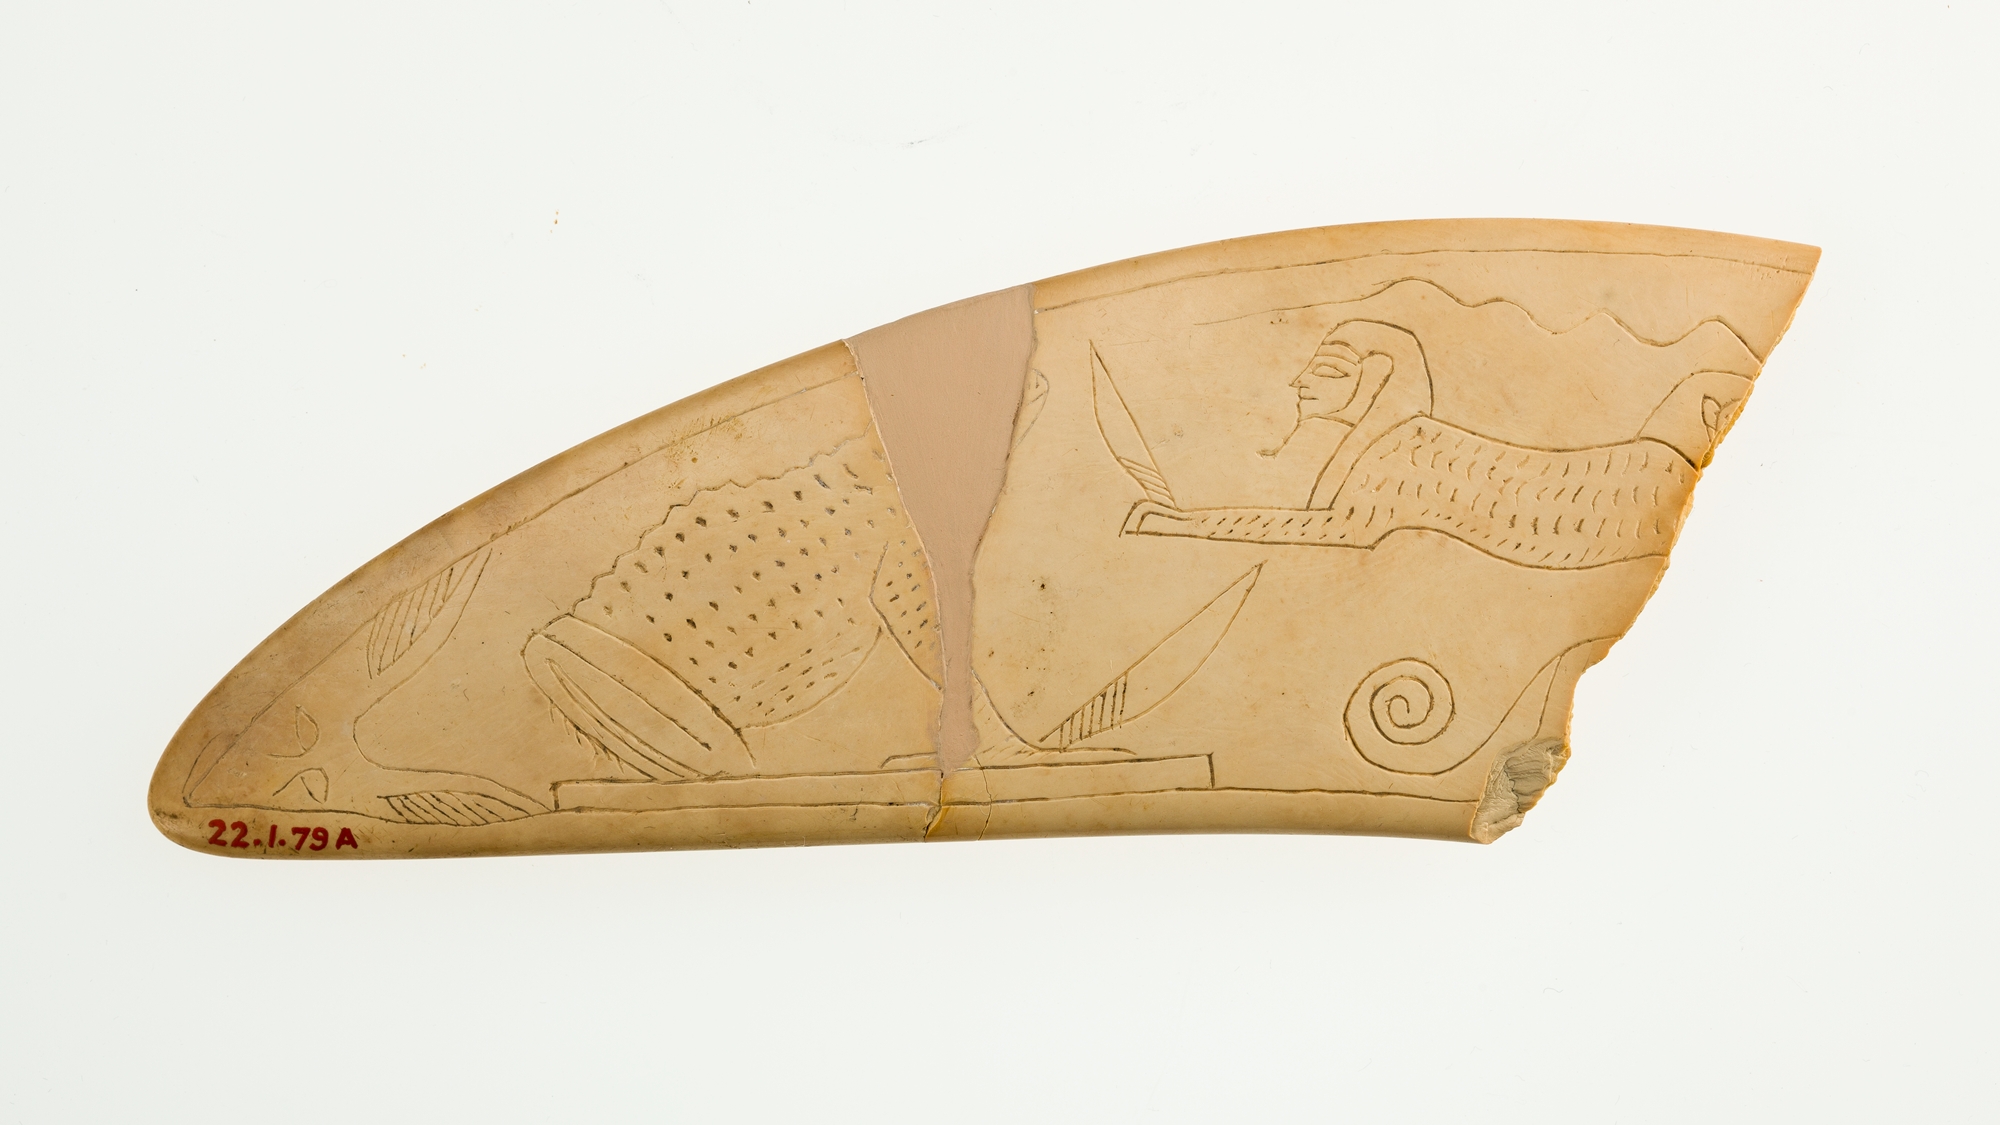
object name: magic wand fragment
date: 1850-1775 BCE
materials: ivory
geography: egypt